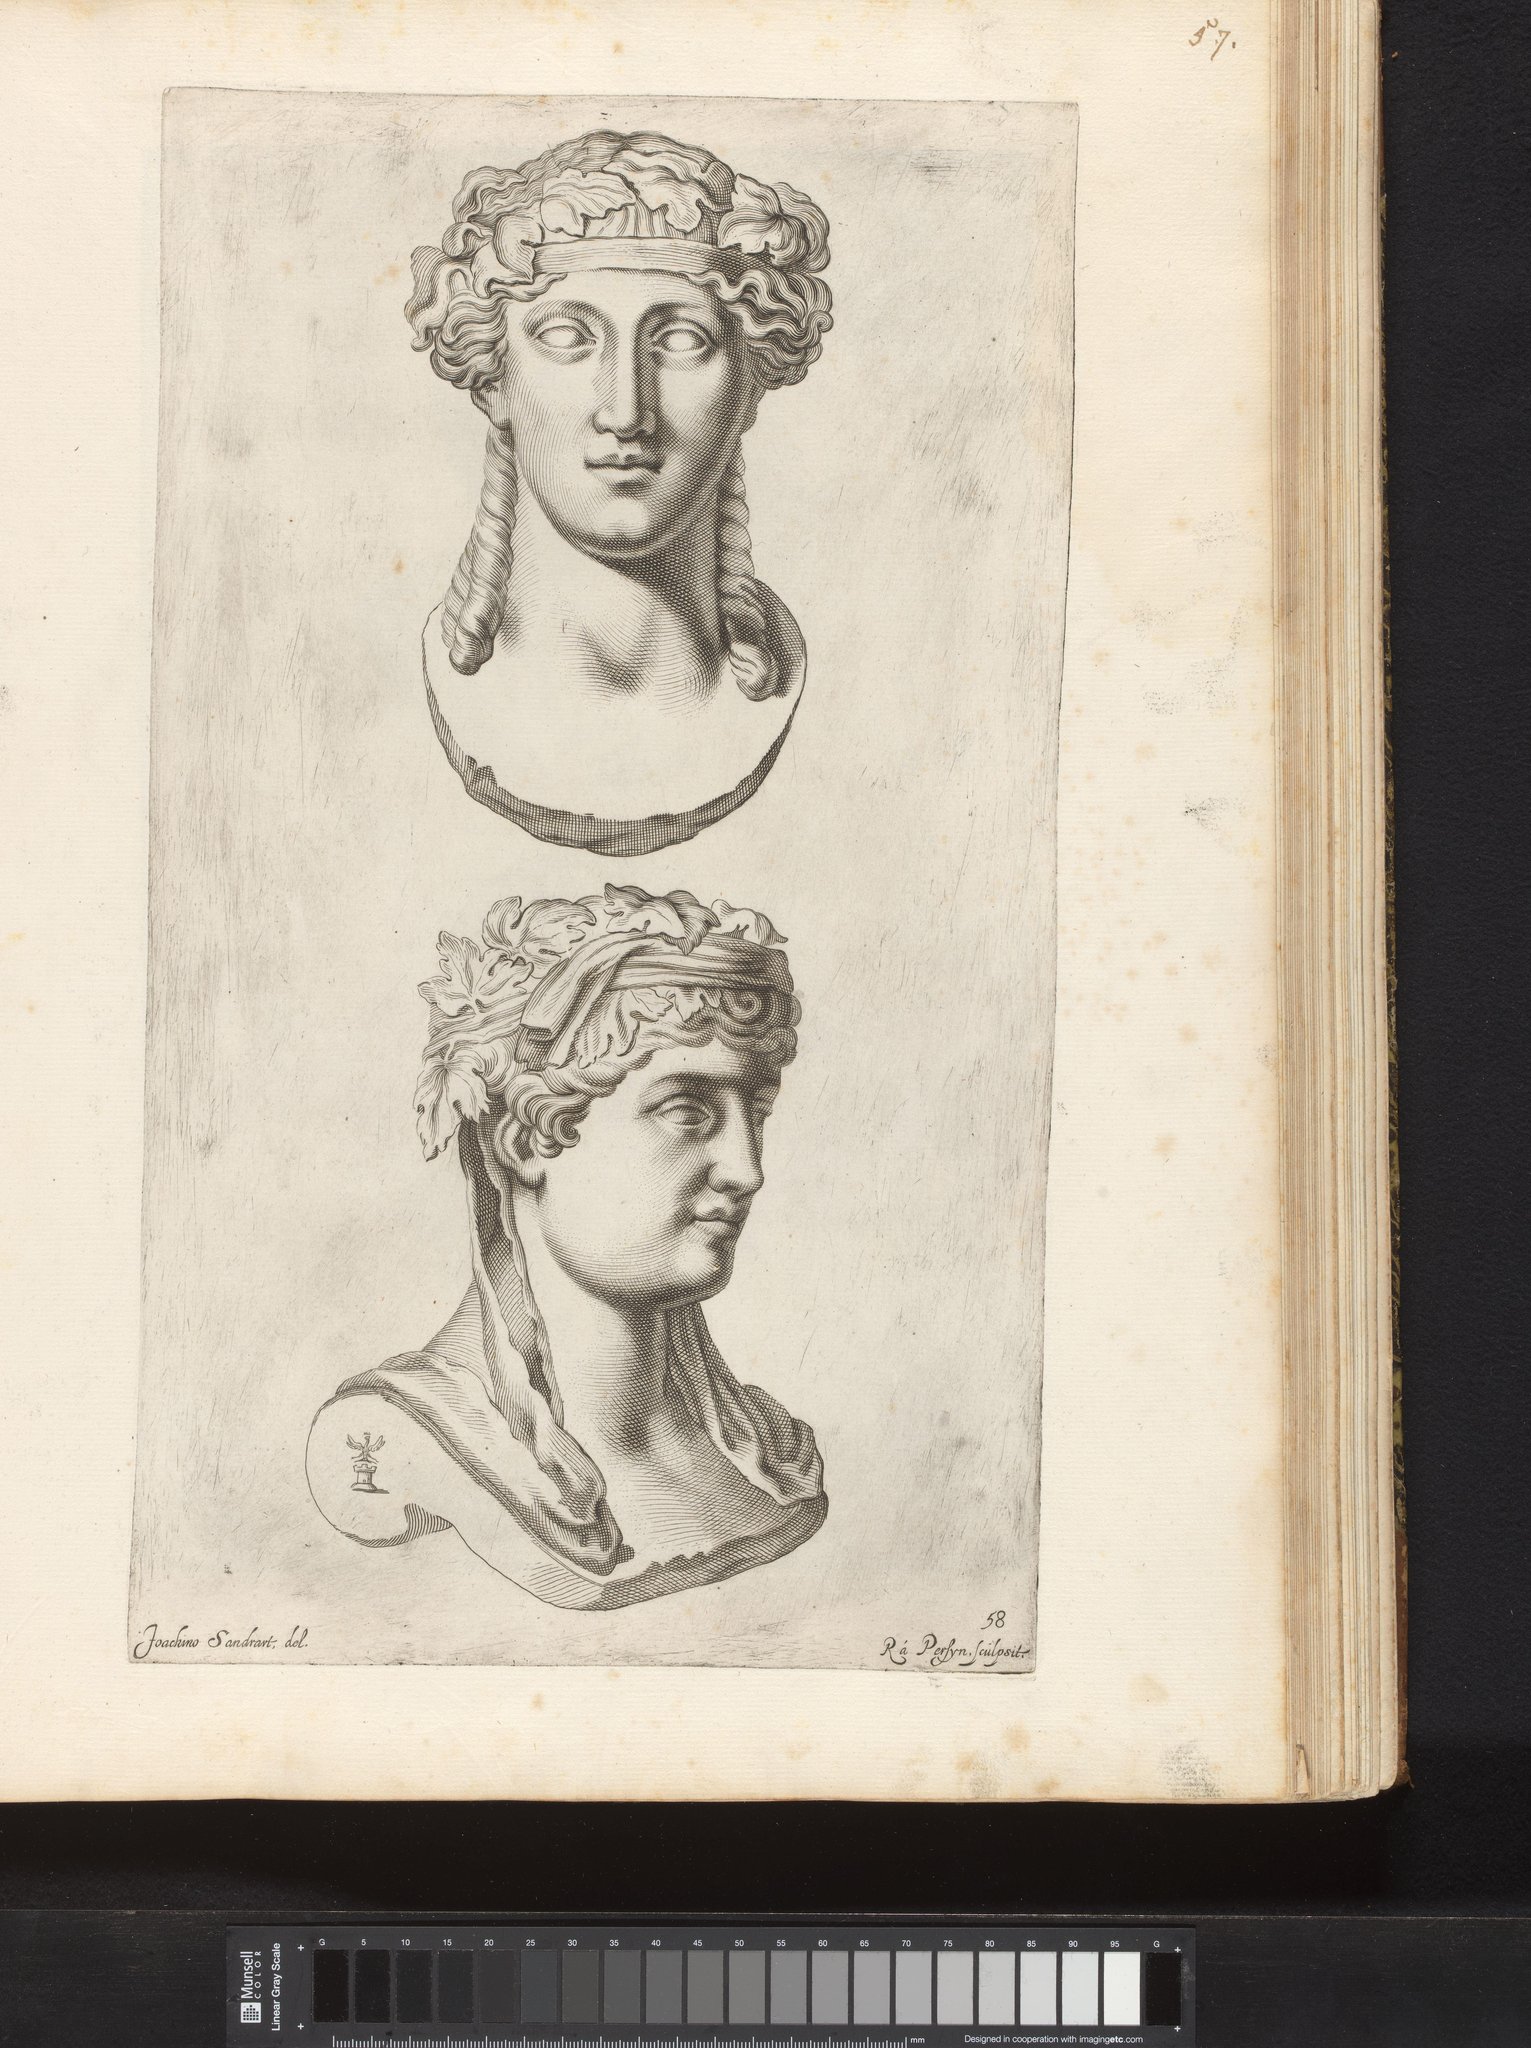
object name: album leaf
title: Galleria Giustiniana del Marchese Vincenzo Giustiniani II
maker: johann friedrich greuter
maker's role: print maker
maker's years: 1589-1662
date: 1636-1647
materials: paper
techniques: engraving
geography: rome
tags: piece of sculpture, reproduction of a piece of sculpture, amalthea, the nymph, usually in the shape of a goat, suckles the new-born jupiter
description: De kleine Jupiter wordt gevoed door de nimf Amalthea. Jupiter drinkt geitenmelk uit een hoorn. Midden onder het wapenschild van Vincenzo Giustiniani, die dit bas-reliëf in zijn bezit had. Prent maakt deel uit van een album met een serie prenten naar de sculpturen in de verzameling in de Galleria Giustiniani te Rome.